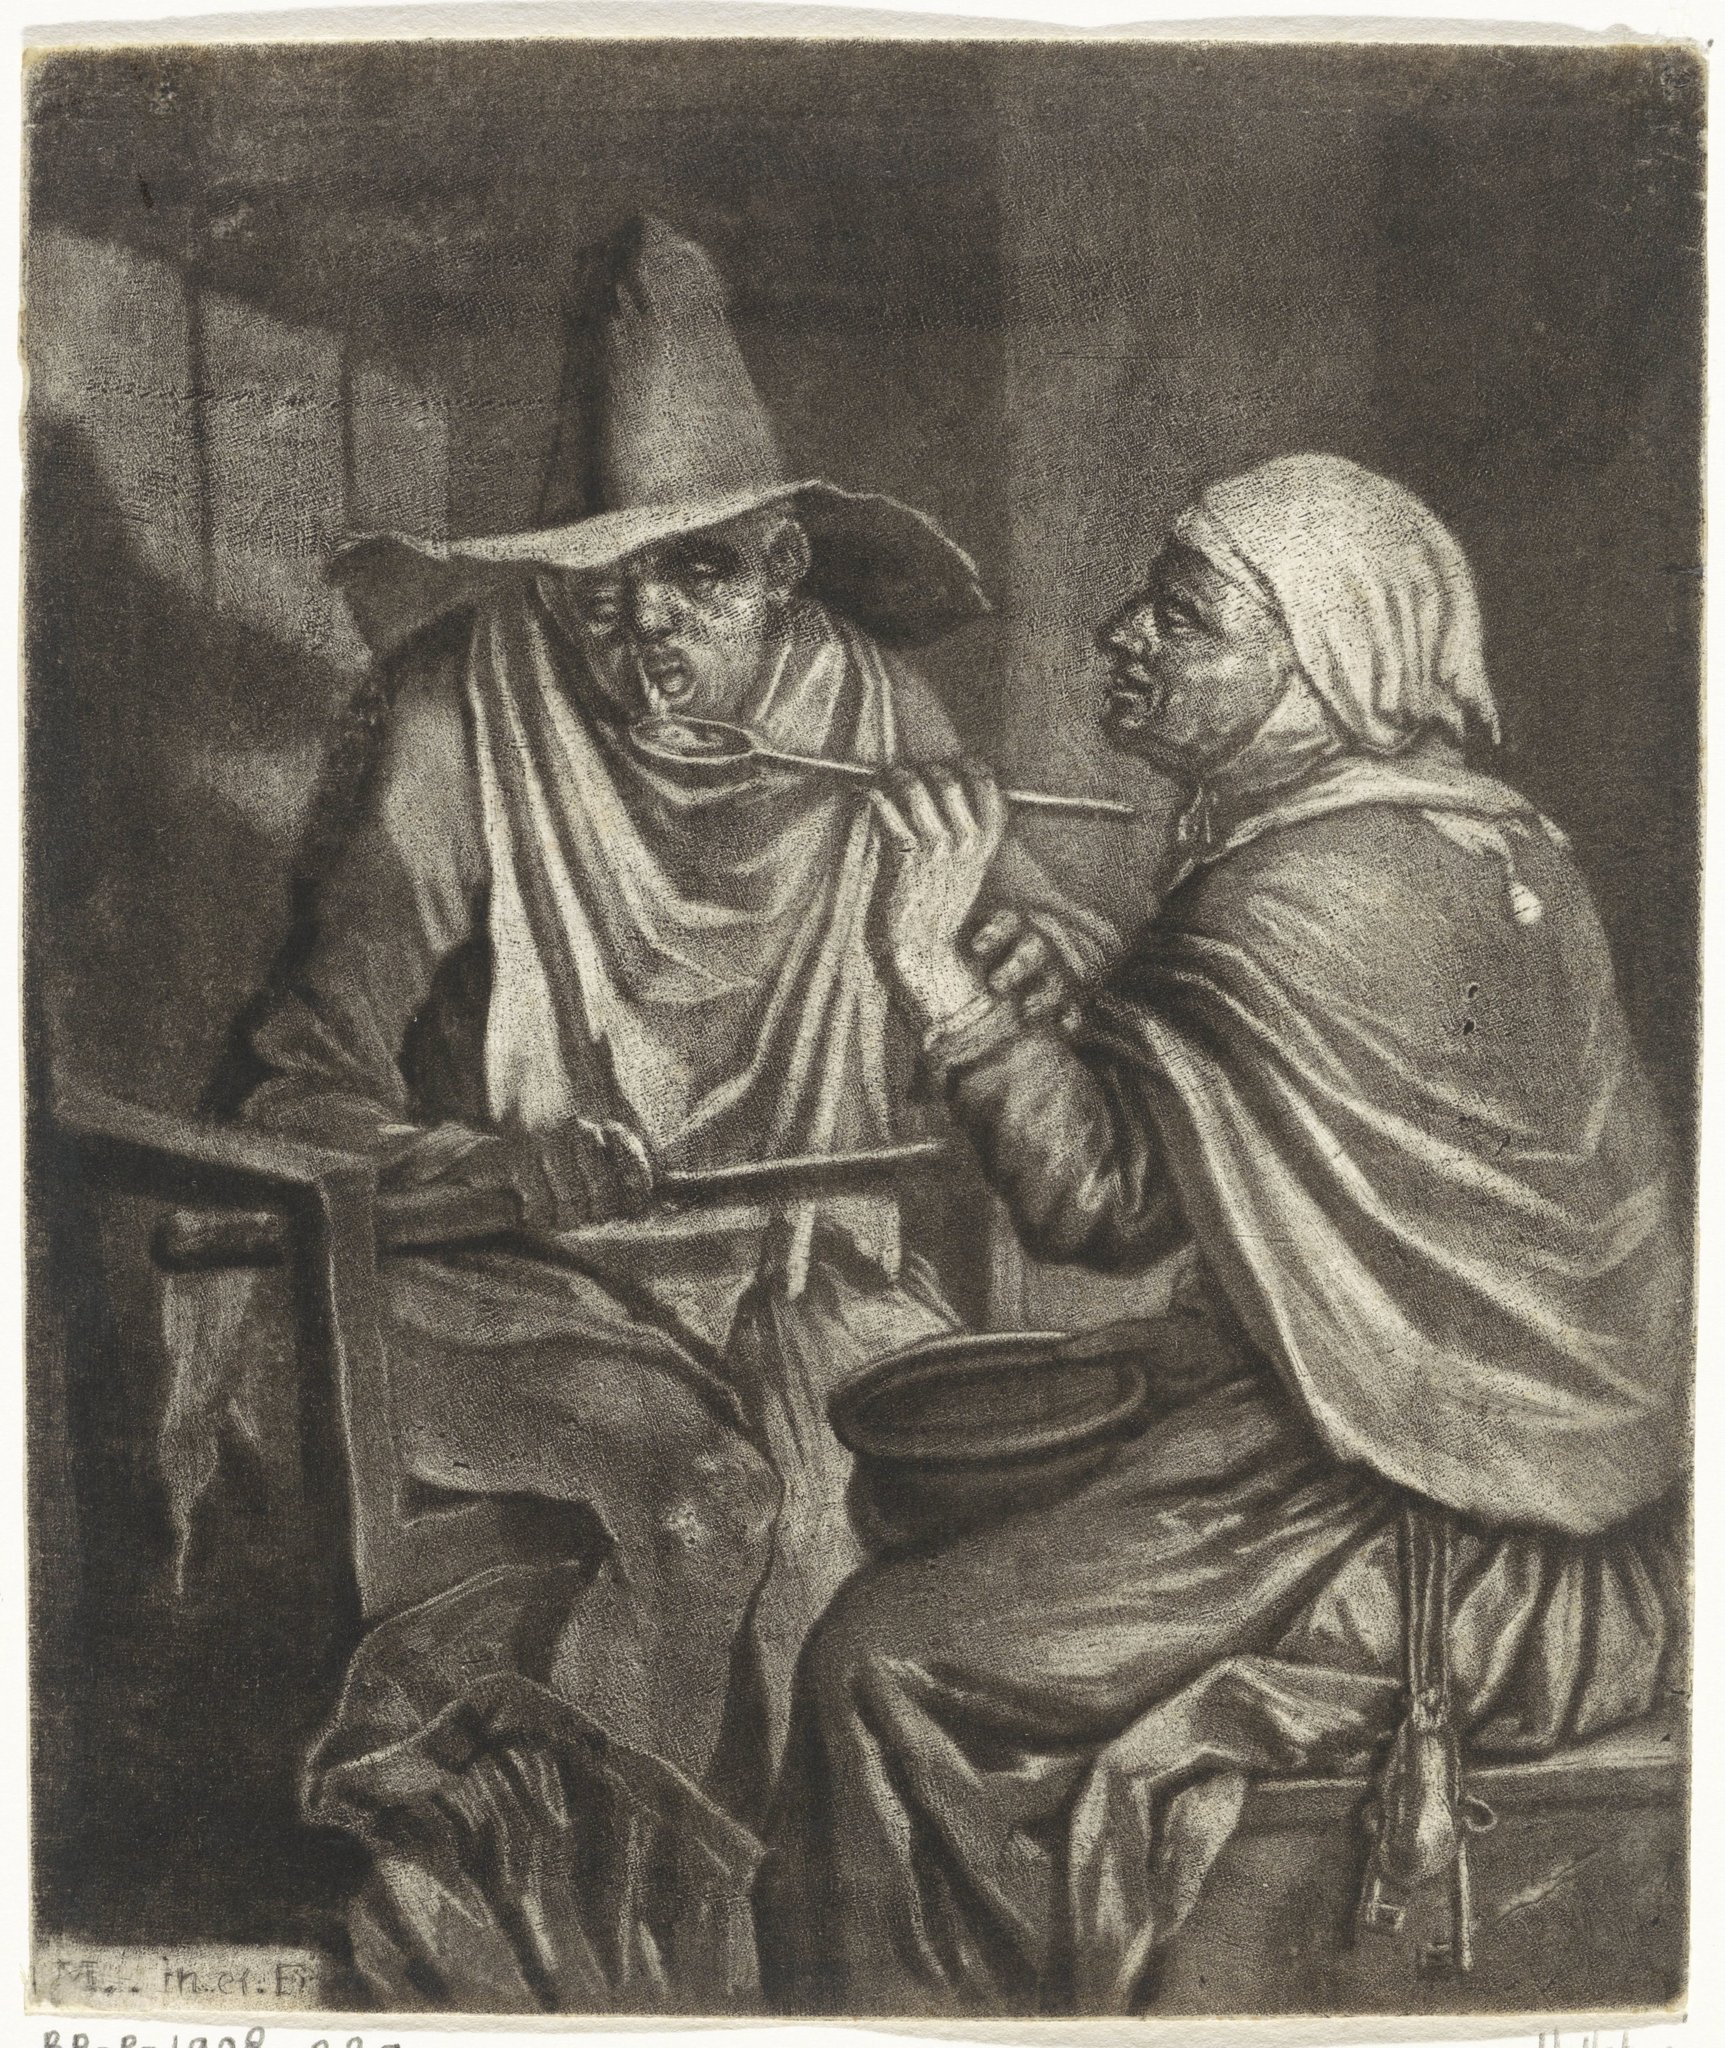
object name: print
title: Oude vrouw voert een man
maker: marcellus laroon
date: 1663-1702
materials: paper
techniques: mezzotint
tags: giving food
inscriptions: collector's mark: Lugt 2228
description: Een oude vrouw voert een man met een grote lepel. De man draagt een hoed.